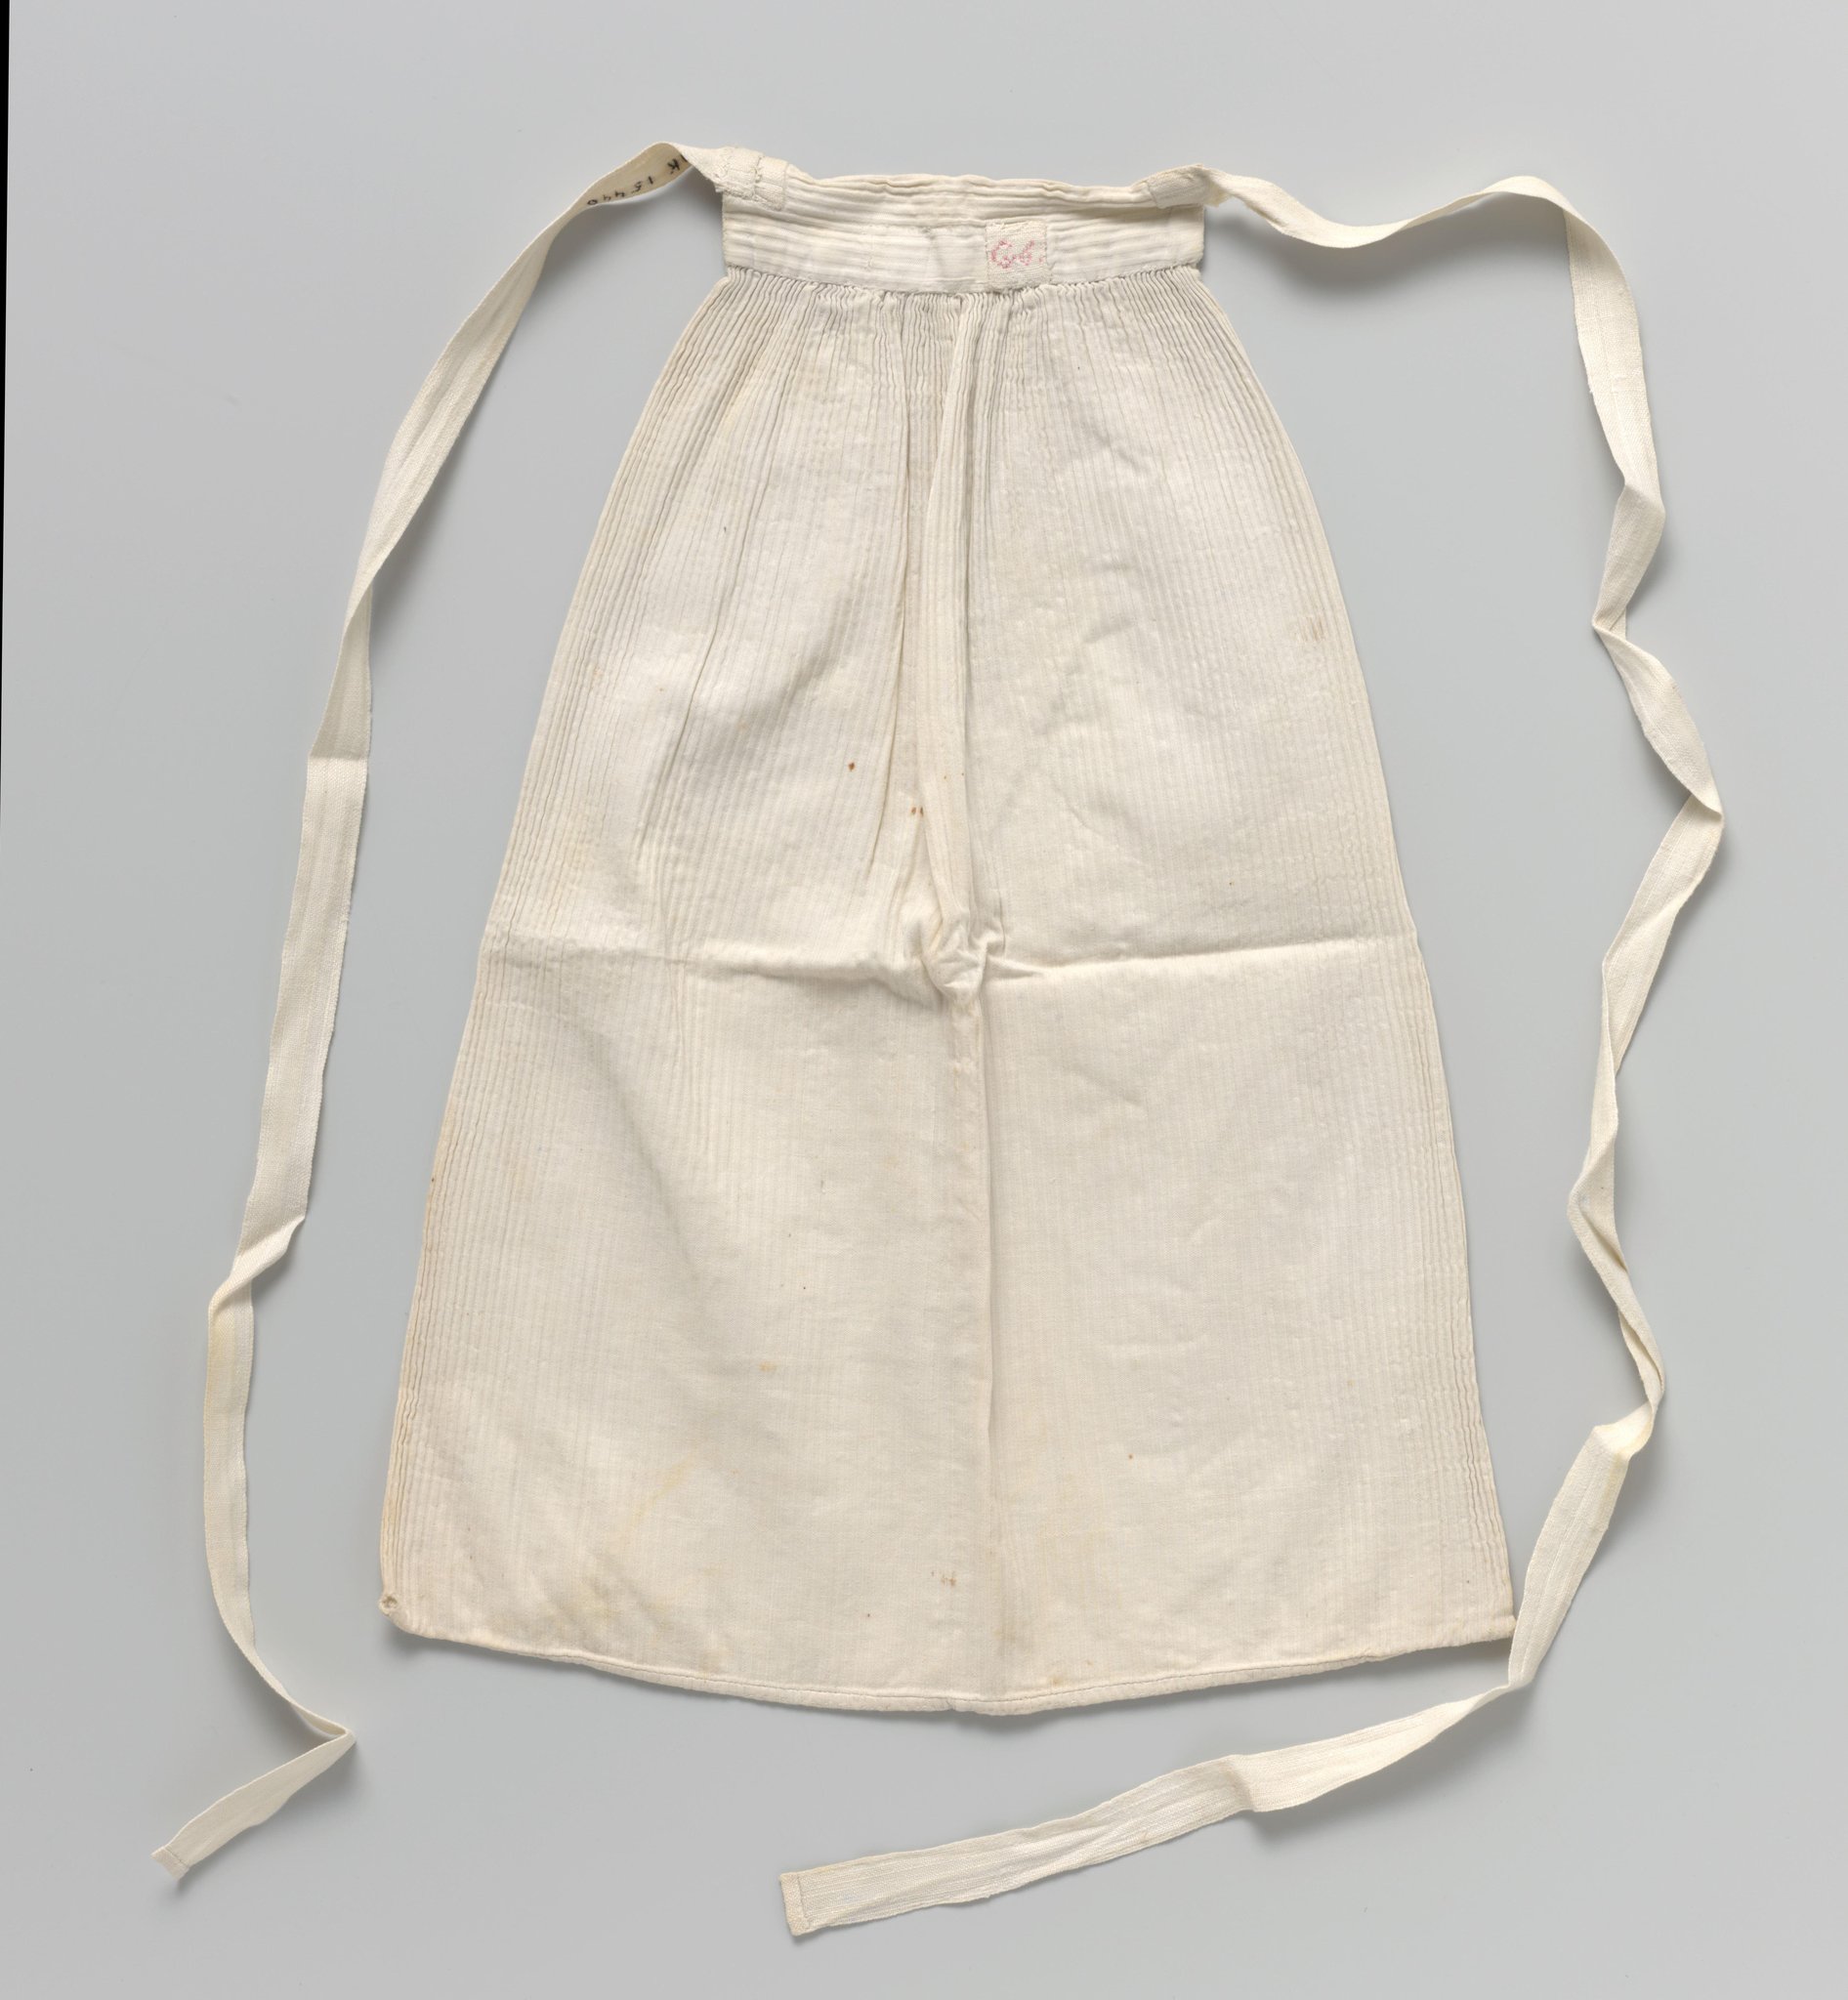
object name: pocket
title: Rokzak van wit katoen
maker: Anonymous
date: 1850-1920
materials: cotton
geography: europe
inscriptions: initials: ‘G6’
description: Het textiel heeft een ingeweven patroon van verticale lijnen.